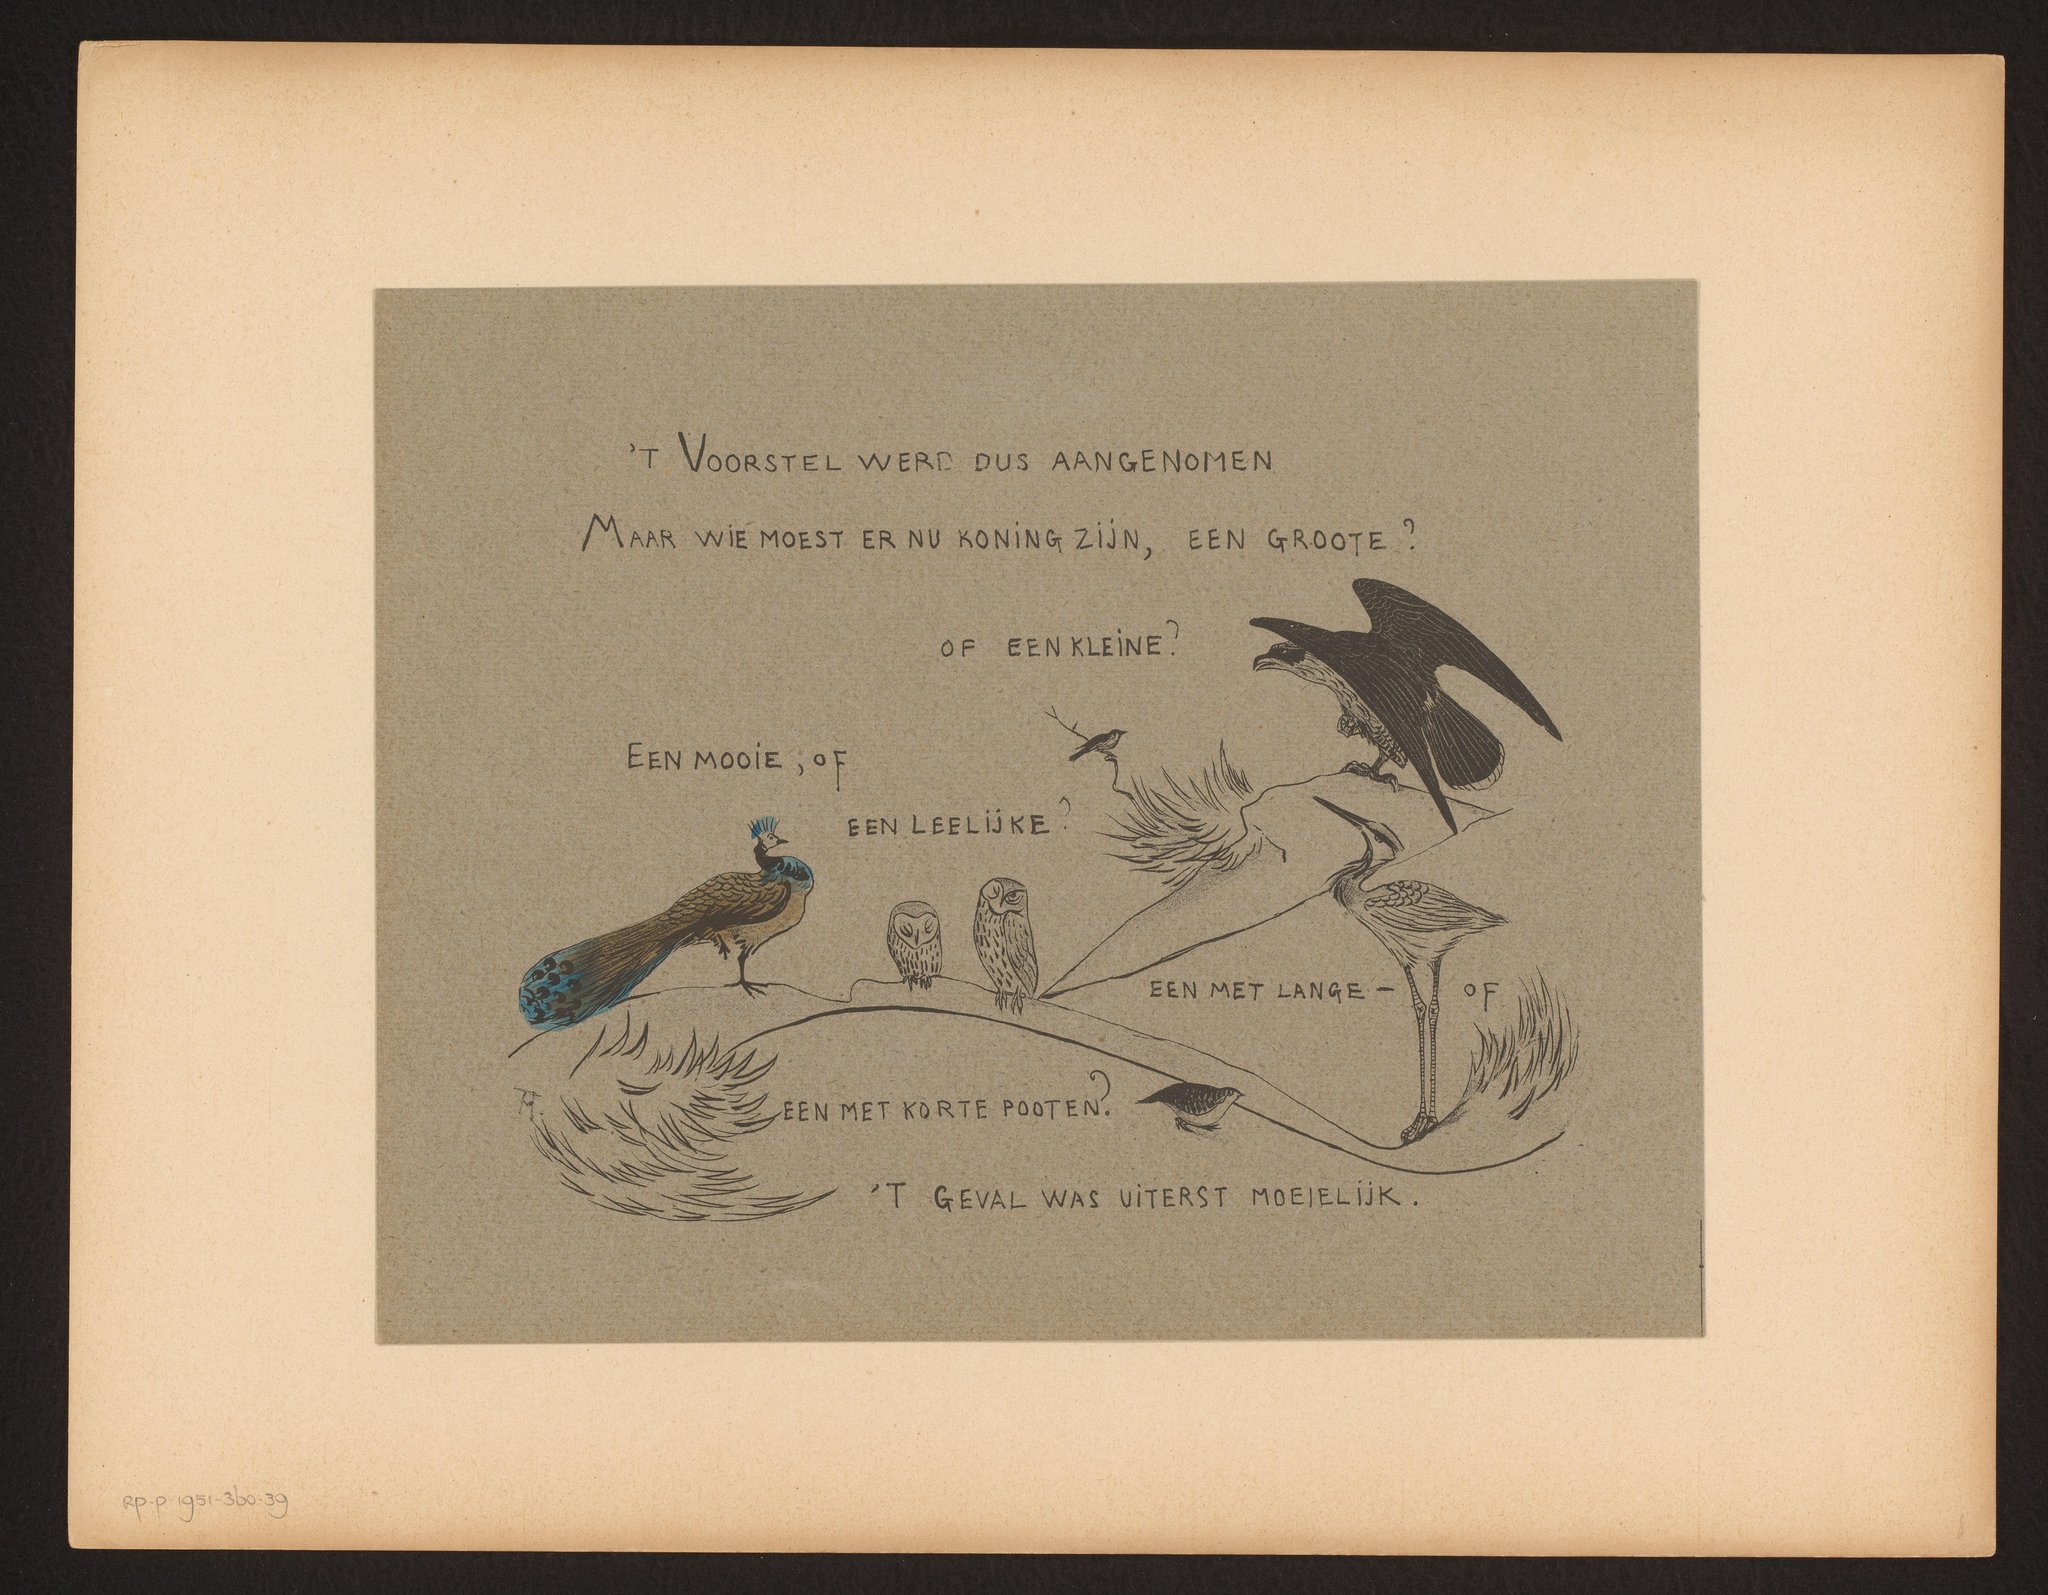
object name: print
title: Tekstblad met onder andere pauw, uilen, reiger en roofvogel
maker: theo van hoytema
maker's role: draughtsman, painter, print maker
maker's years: 1863-1917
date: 1892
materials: paper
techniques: hand coloring, lithograph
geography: the hague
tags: shore-birds and wading-birds: heron, ornamental birds: peacock, predatory birds, owls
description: Zowel tekst als afbeelding zijn gelithografeerd.